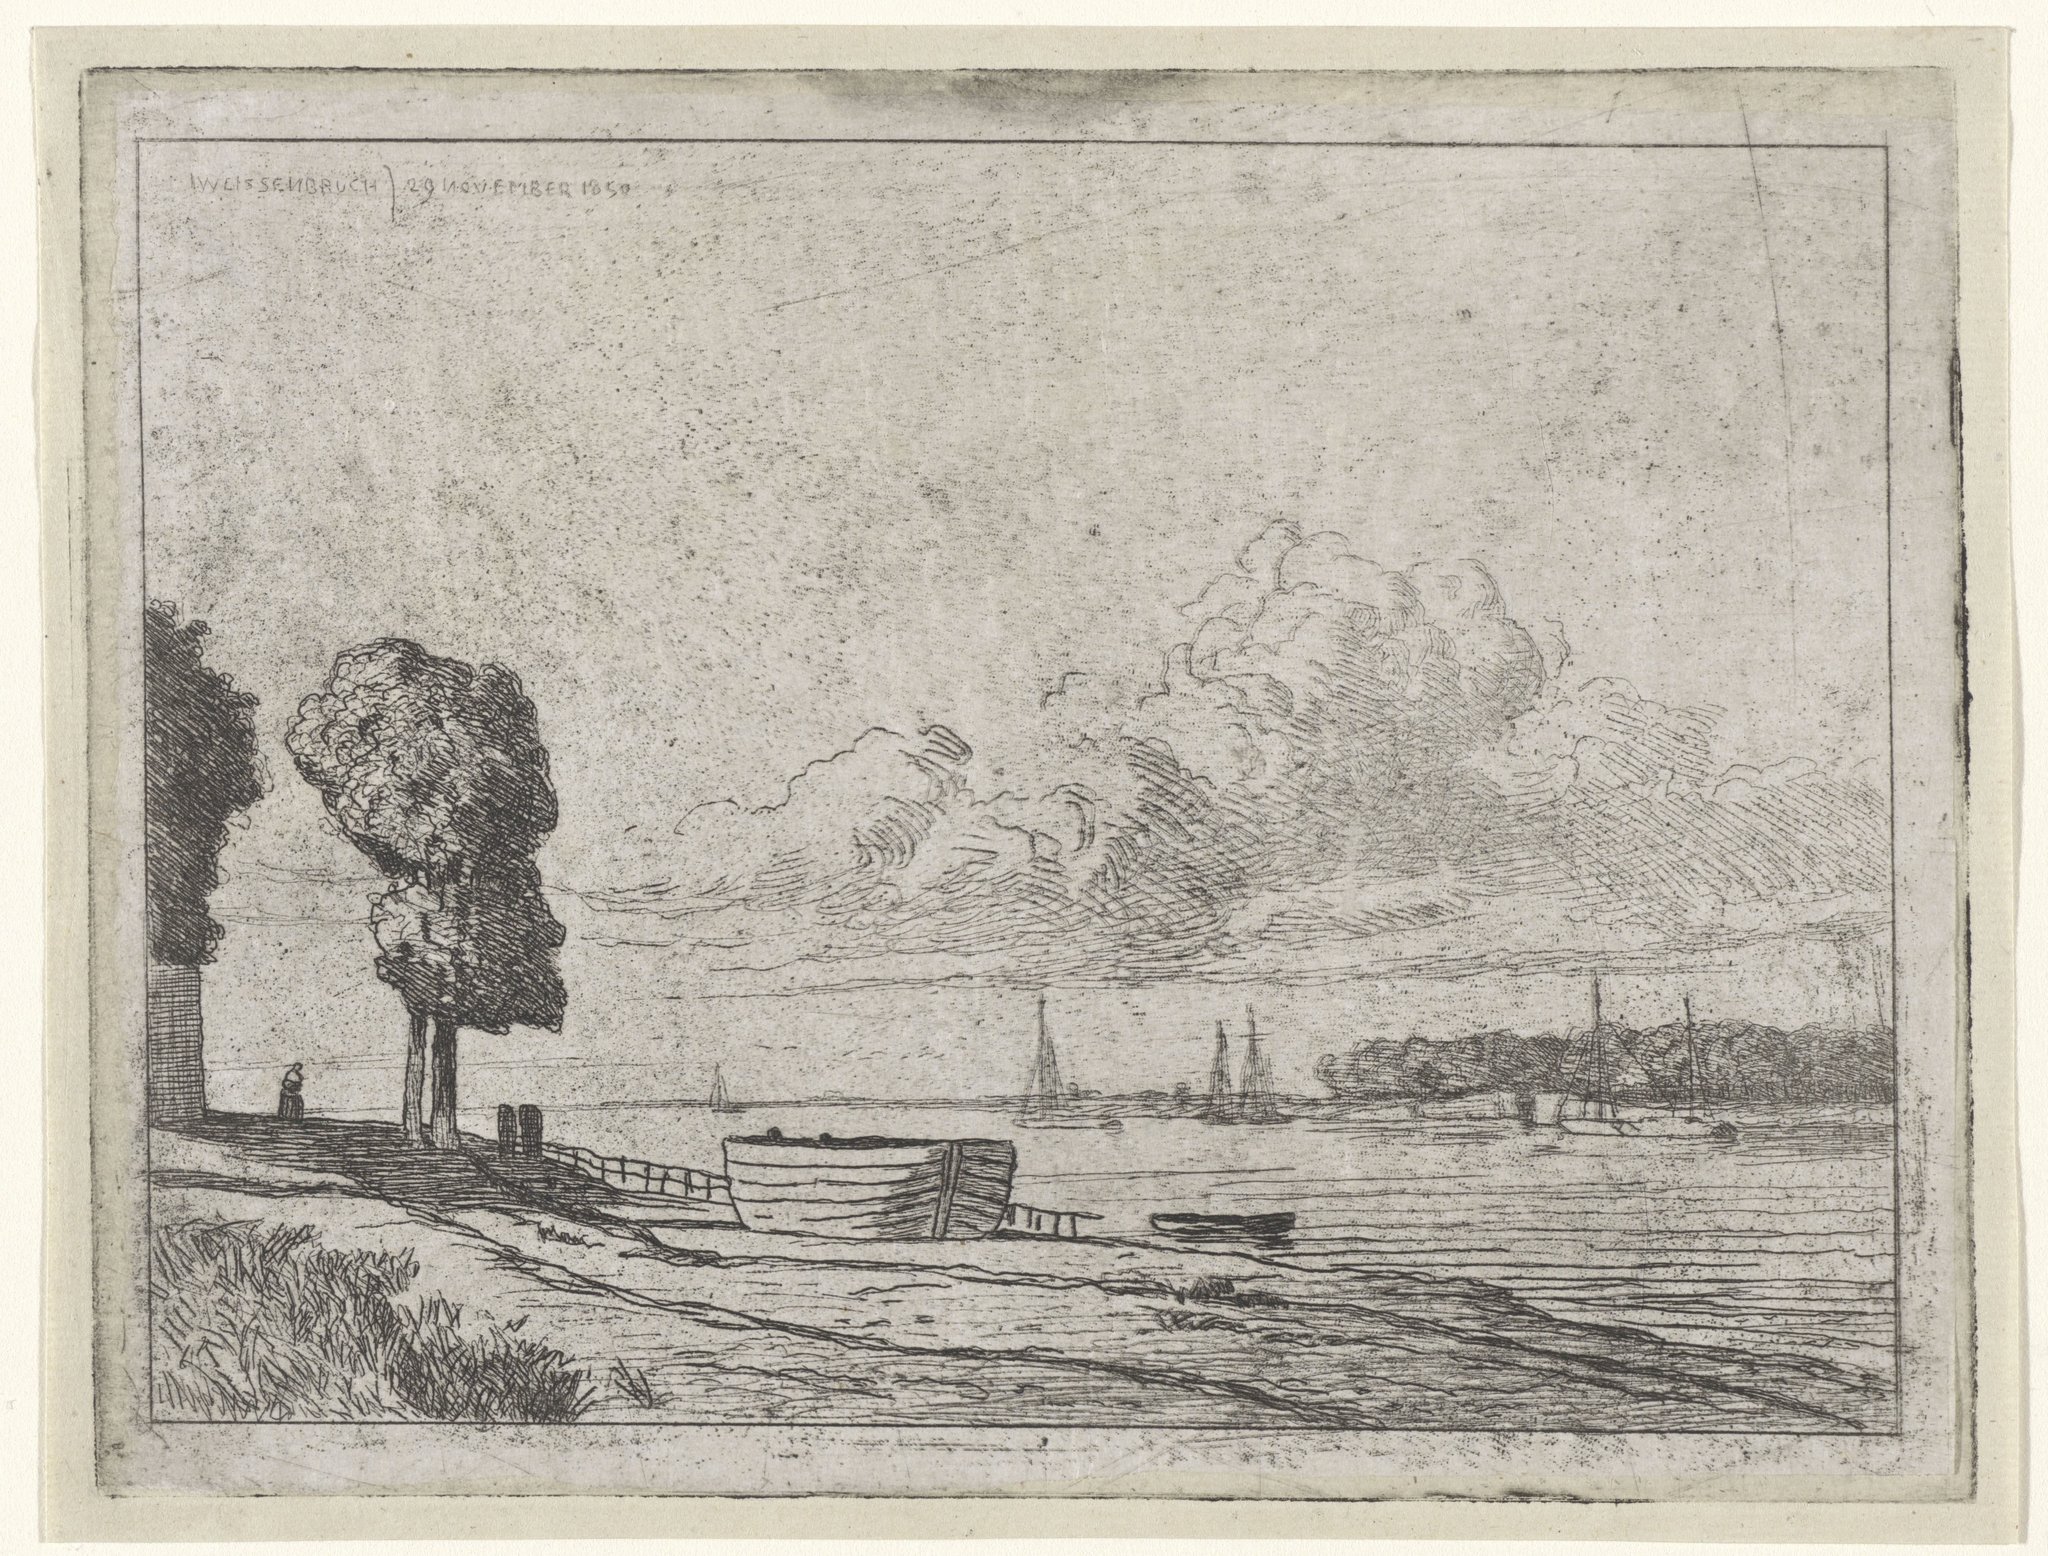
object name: print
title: Gezicht op de rivier de Lek bij Vreeswijk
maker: jan weissenbruch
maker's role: painter, print maker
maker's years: 1822-1880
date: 1850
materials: paper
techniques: etching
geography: culemborg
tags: trees, sailing-ship, sailing-boat, landscapes, river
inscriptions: collector's mark: Lugt 2228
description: Op de rivier zijn enkele zeilschepen te zien. Links ligt een boot op de kant. Op het pad ernaast is een figuur weergegeven.